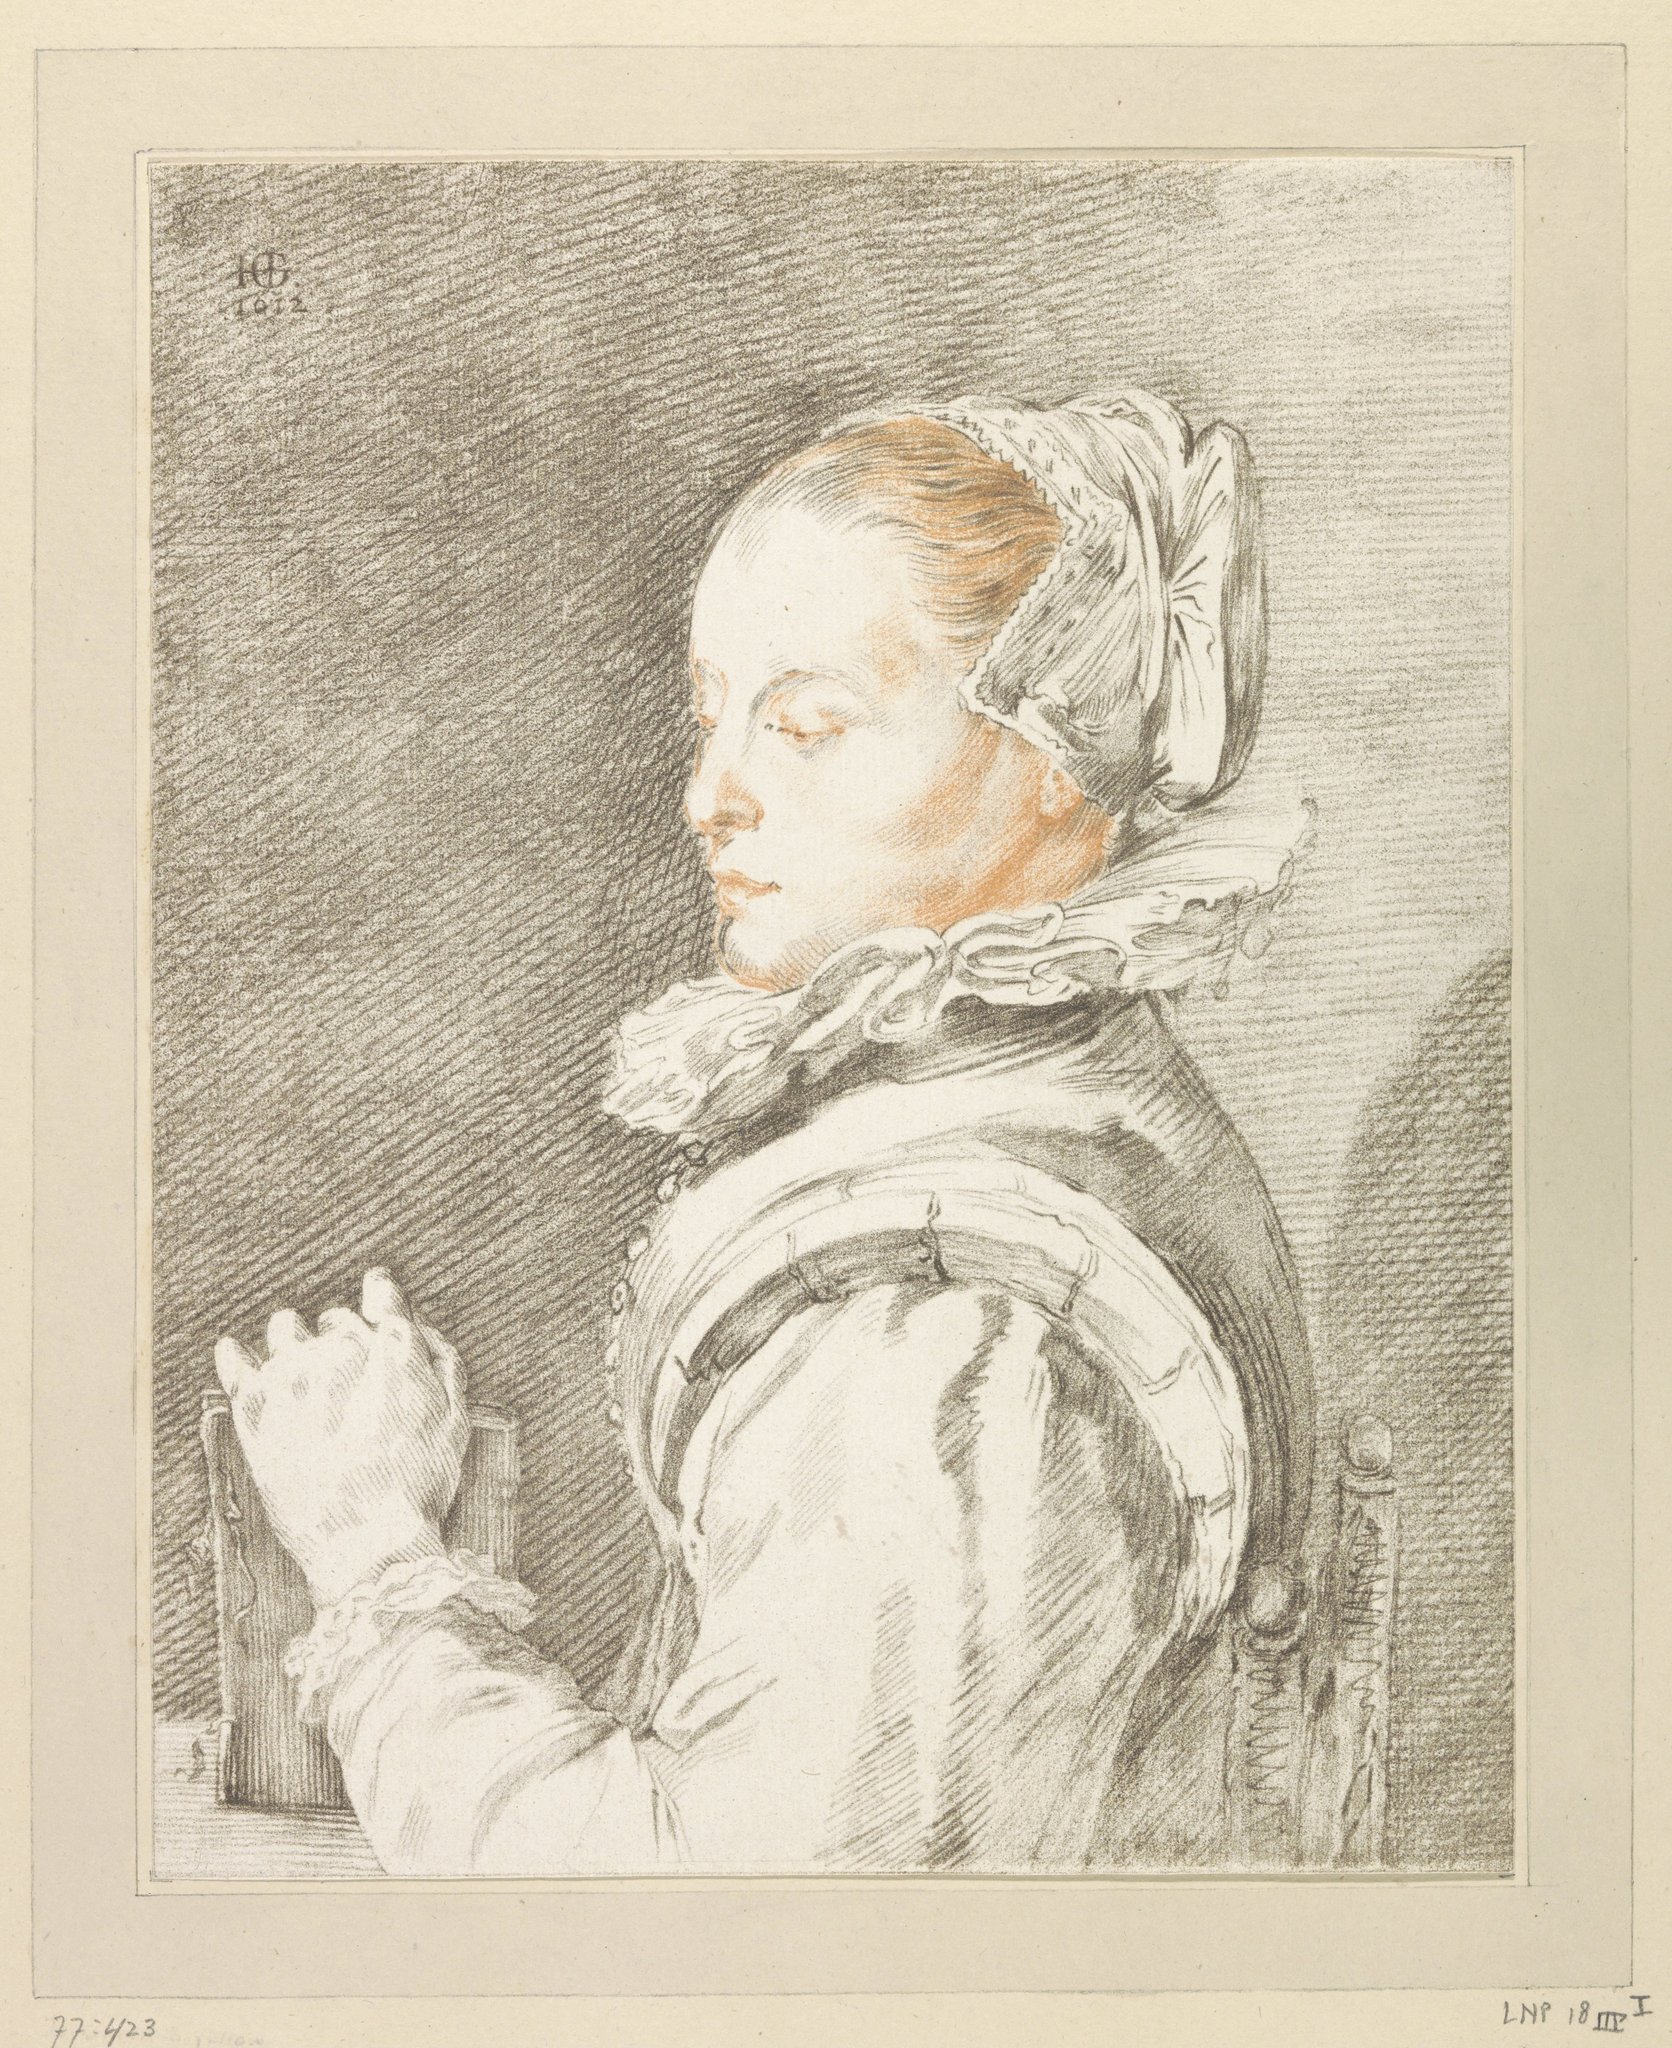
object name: print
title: Portret van een jonge vrouw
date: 1770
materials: paper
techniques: printmaking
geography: amsterdam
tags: maria tesselschade roemers visscher, adult woman, book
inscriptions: inscription: ‘2de onafgemaakte proef voor dheer en ..... L Matayer/ CPvAmstel// H Goltzius del 1612/ CPvAmstel 1770’, collector's mark: Lugt 2228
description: Naar een tekening van Hendrick Goltzius in het Amsterdam Museum. Vanaf de achttiende eeuw werd de geportretteerde, onder andere door Cornelis Ploos van Amstel, regelmatig aangeduid als zijnde Maria Tesselschade Roemer Visscher, maar dat is onjuist gebleken.